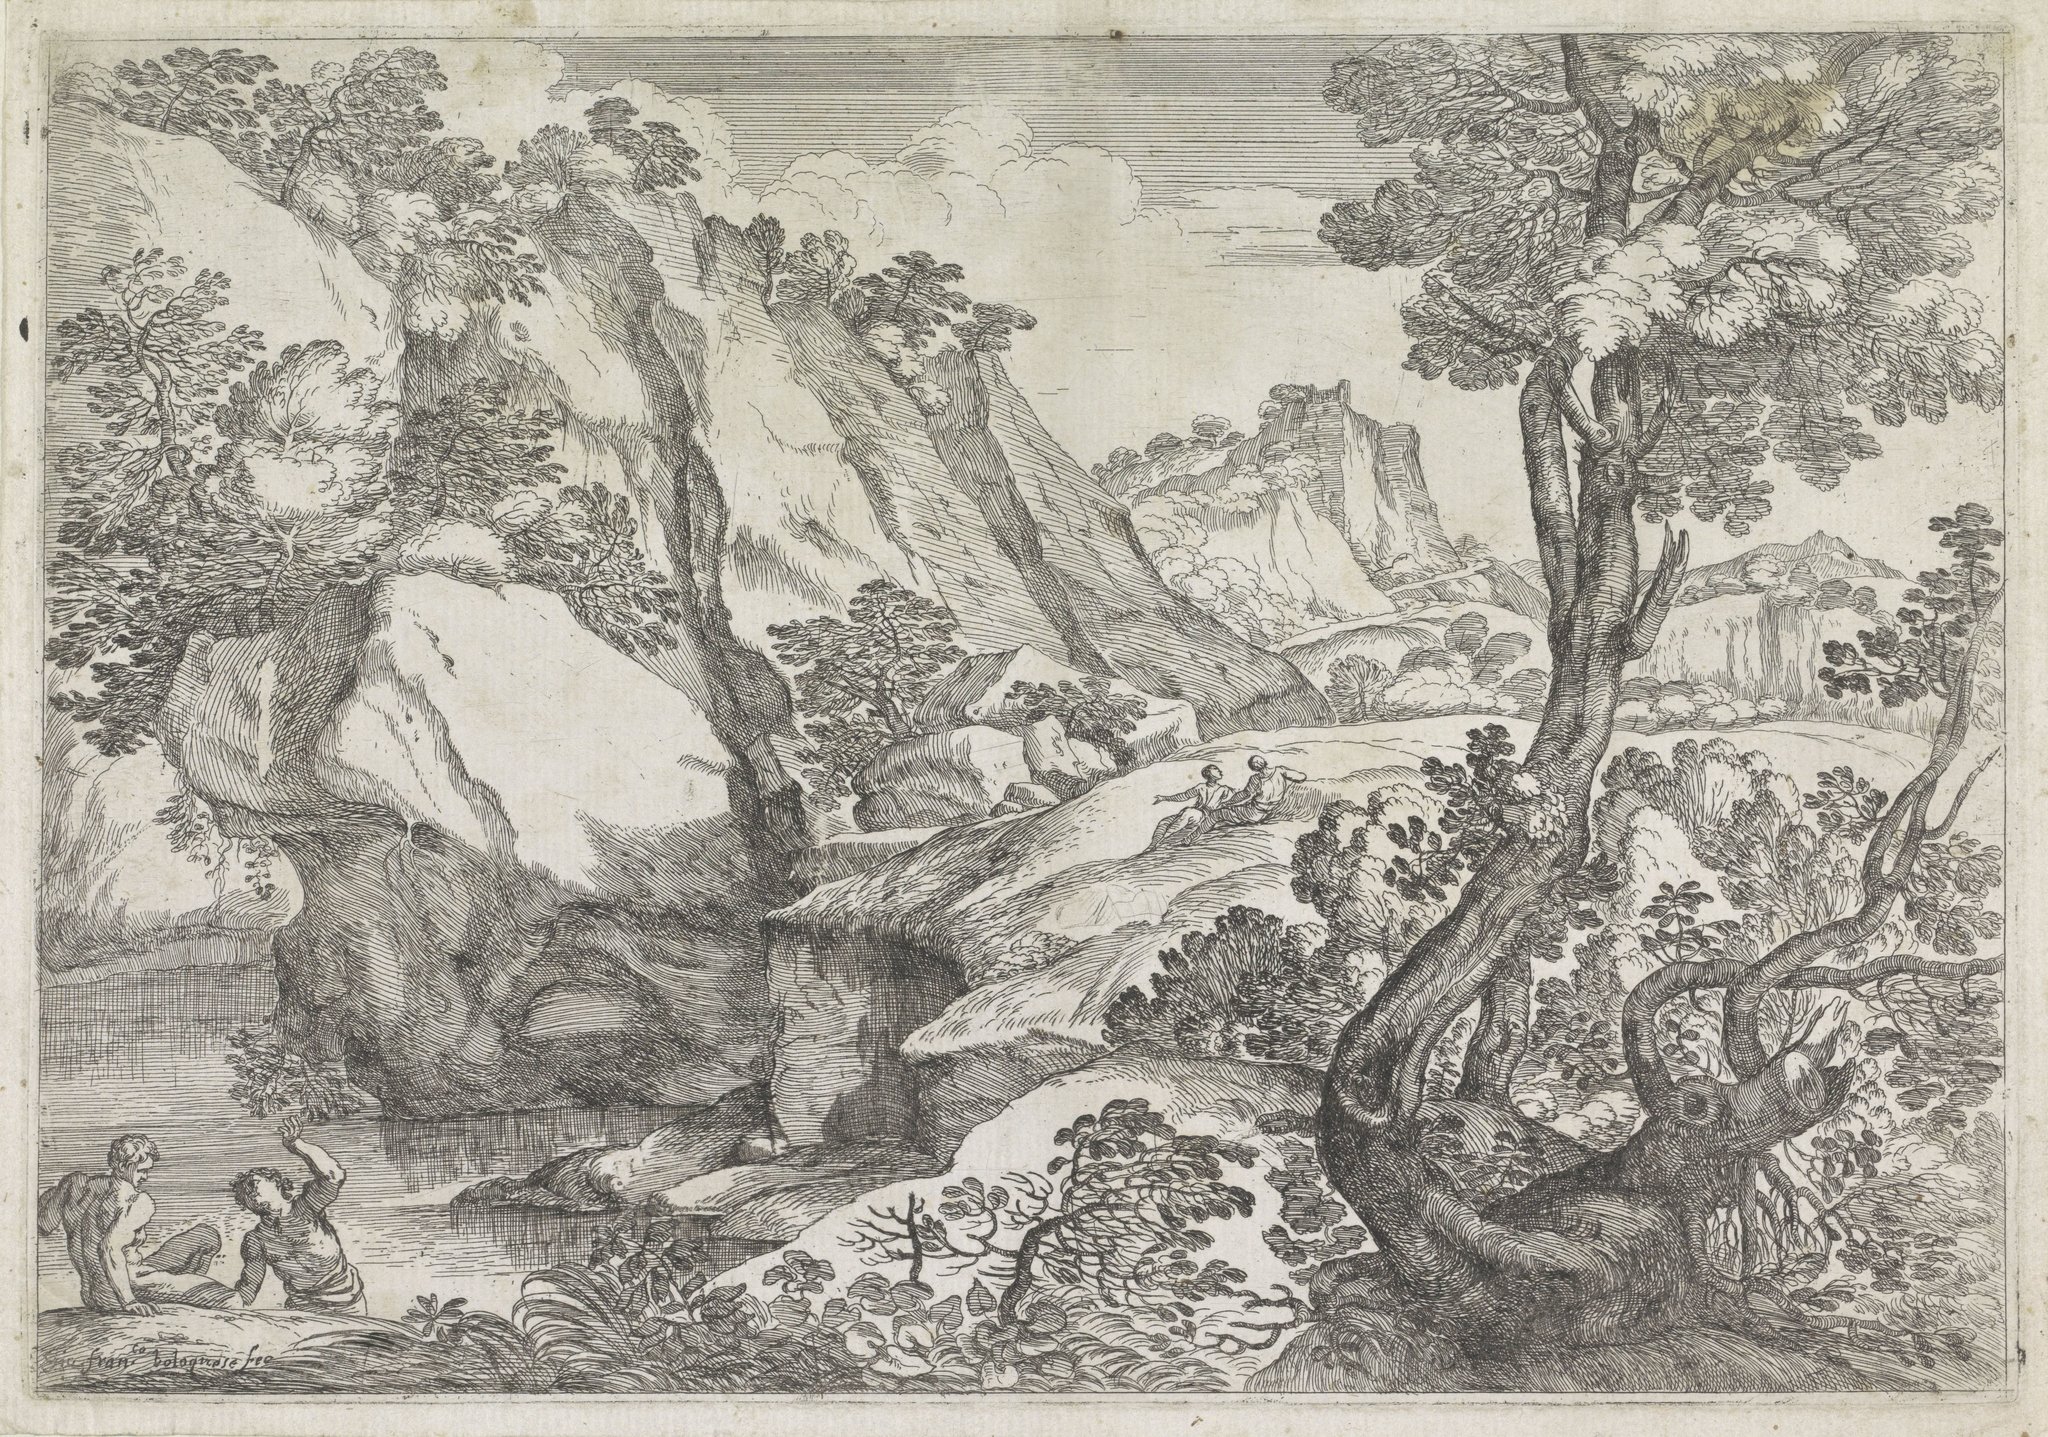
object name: print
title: Landschap met vergroeide boom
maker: giovanni francesco grimaldi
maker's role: draughtsman, print maker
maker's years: 1606-1680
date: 1616-1680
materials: paper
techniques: etching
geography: italy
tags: landscapes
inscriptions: collector's mark: Lugt 240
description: Landschap met heuvels, een meer en op de voorgrond rechts een vergroeide boom. Op de voorgrond twee figuren aan de waterkant.